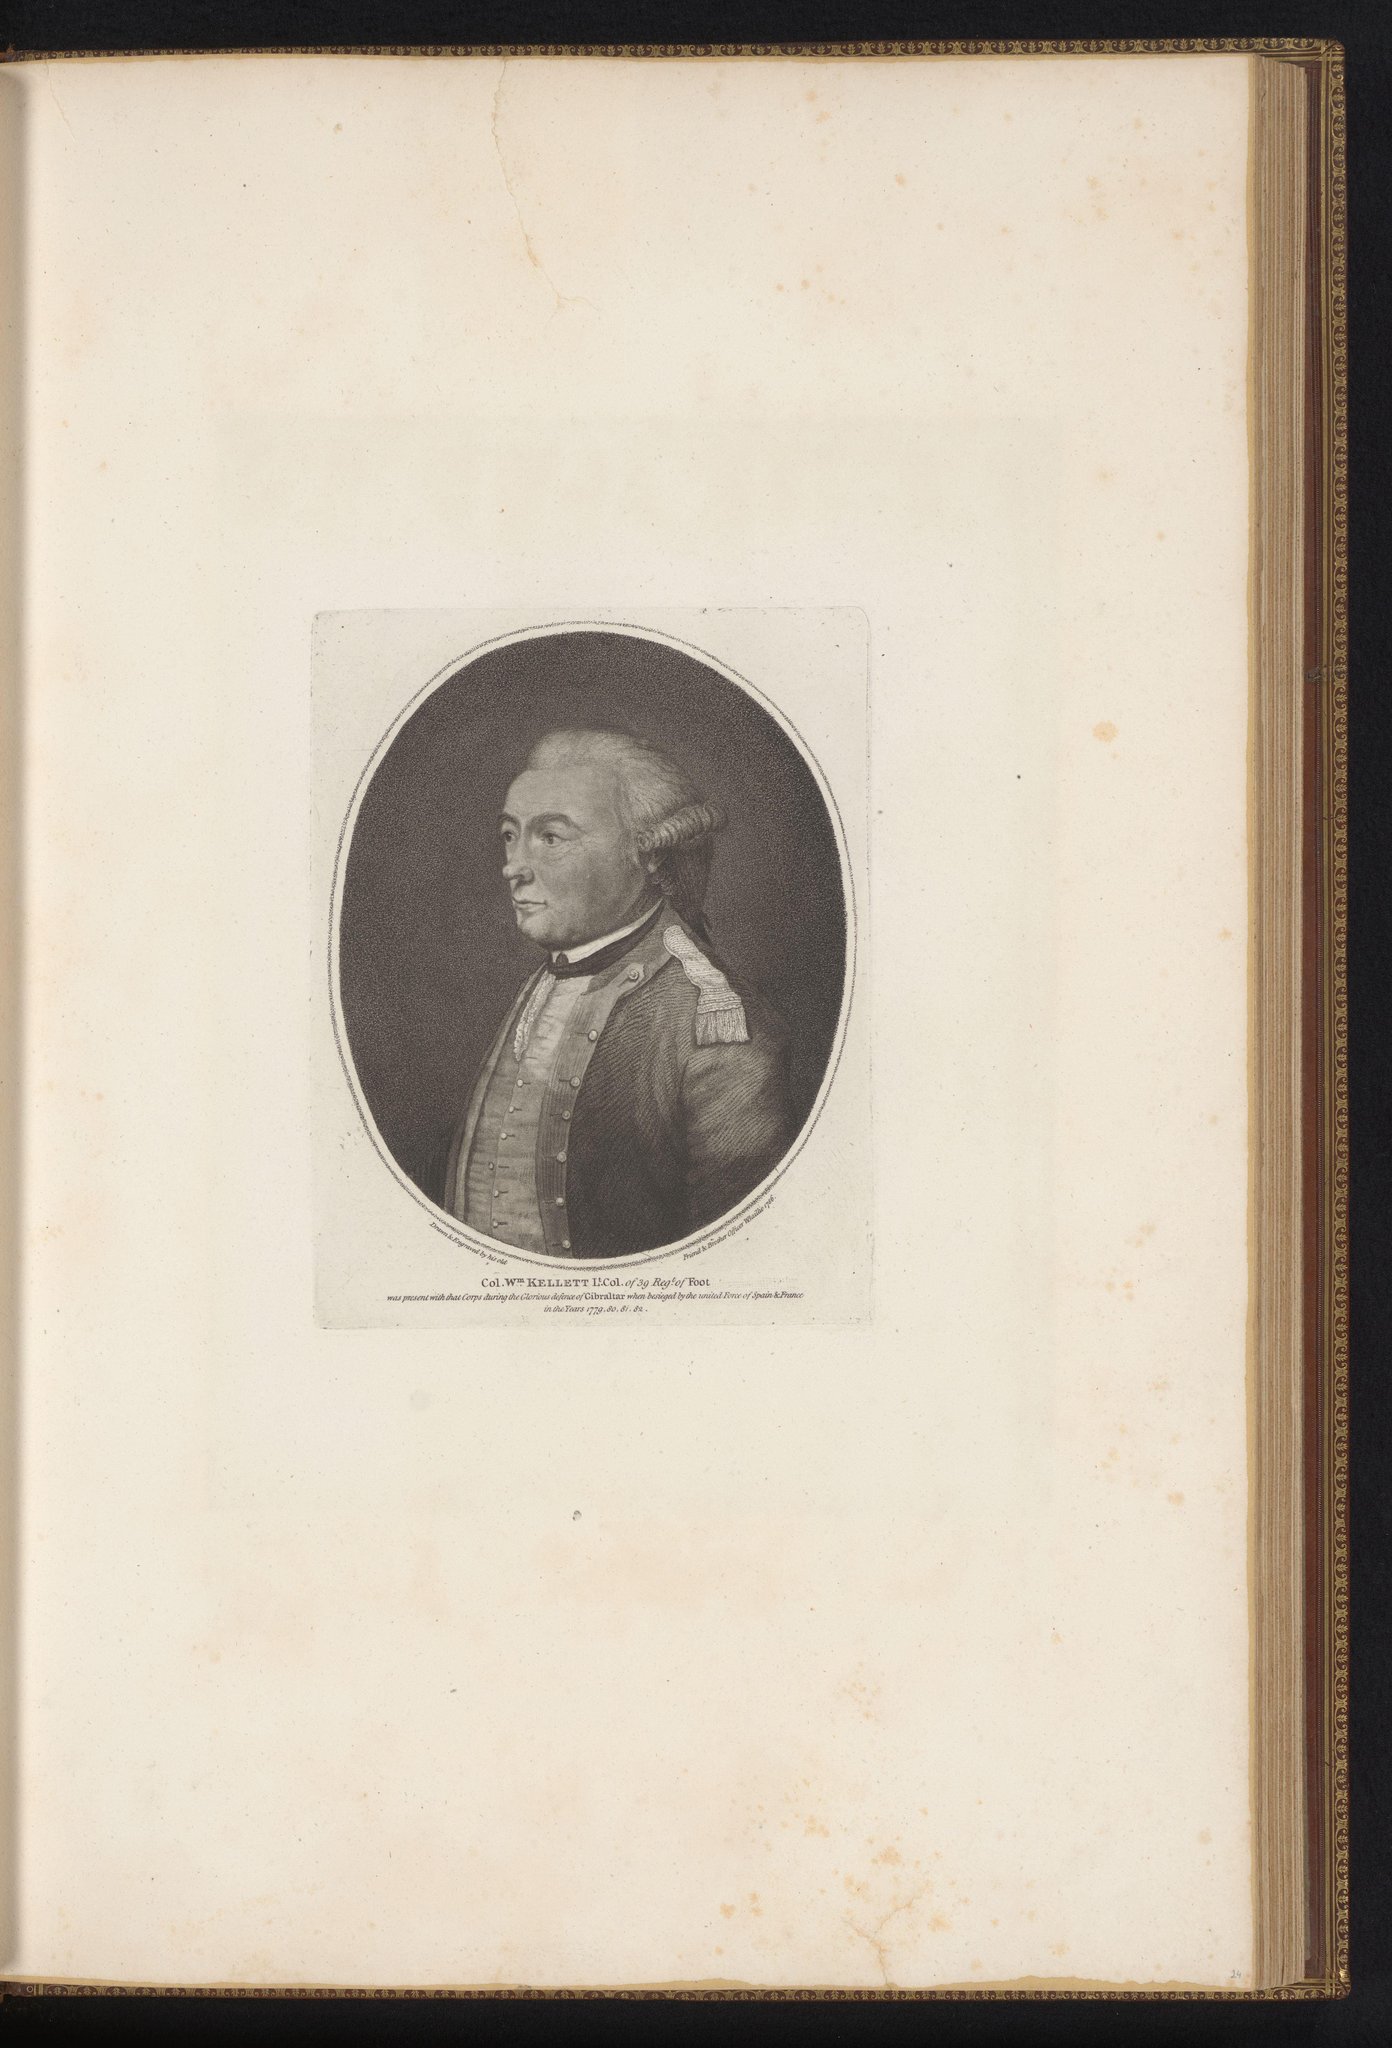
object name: print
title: Portret van William Kellett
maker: william baillie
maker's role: print maker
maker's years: 1723-1810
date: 1786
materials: paper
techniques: etching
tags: soldaat, william kellett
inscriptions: date